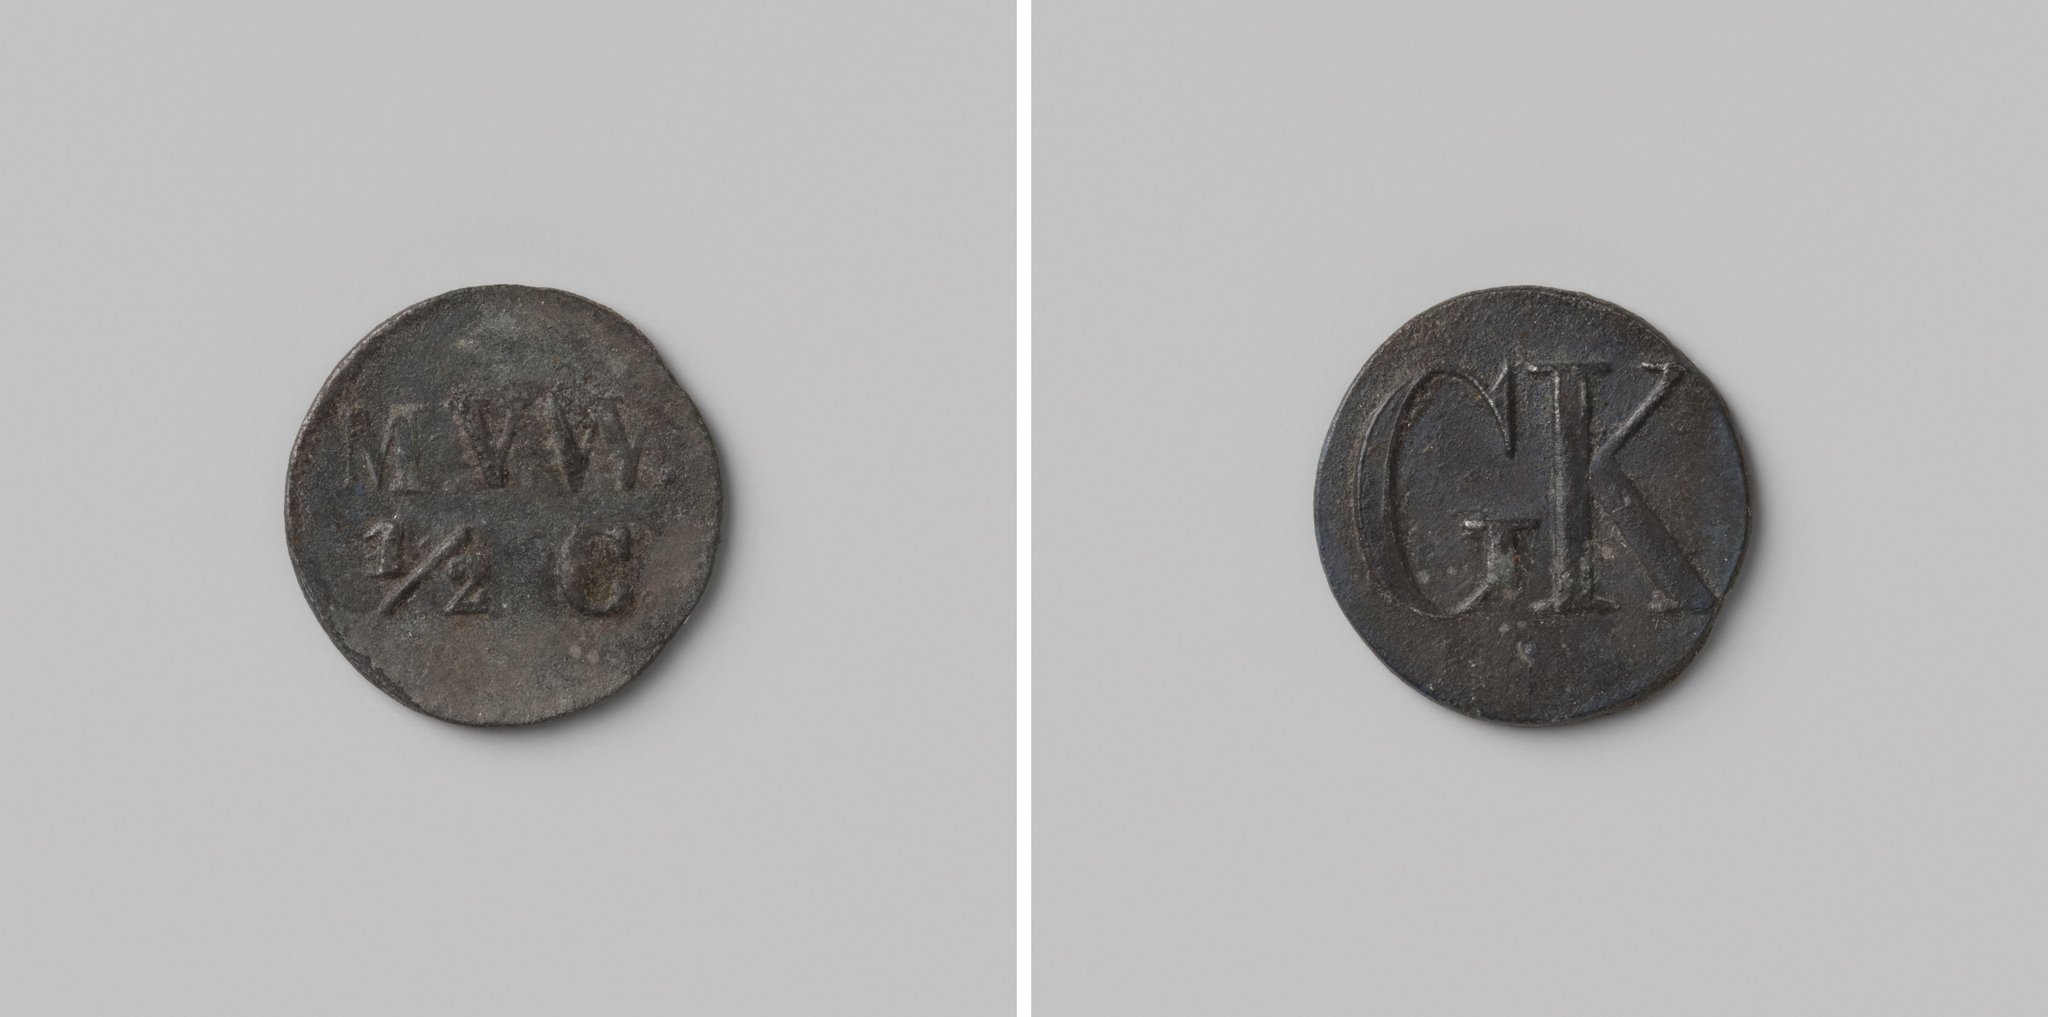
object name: halve cent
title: Huismunt geslagen op last van de Maatschappij van Weldadigheid ter waarde van ½ cent, ten behoeve van de Gewone Koloniën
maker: Anonymous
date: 1818-1859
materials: zinc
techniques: striking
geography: netherlands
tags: maatschappij van weldadigheid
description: Zinken munt. Voorzijde: opschrift boven waardeaanduiding. Keerzijde: opschrift G en K